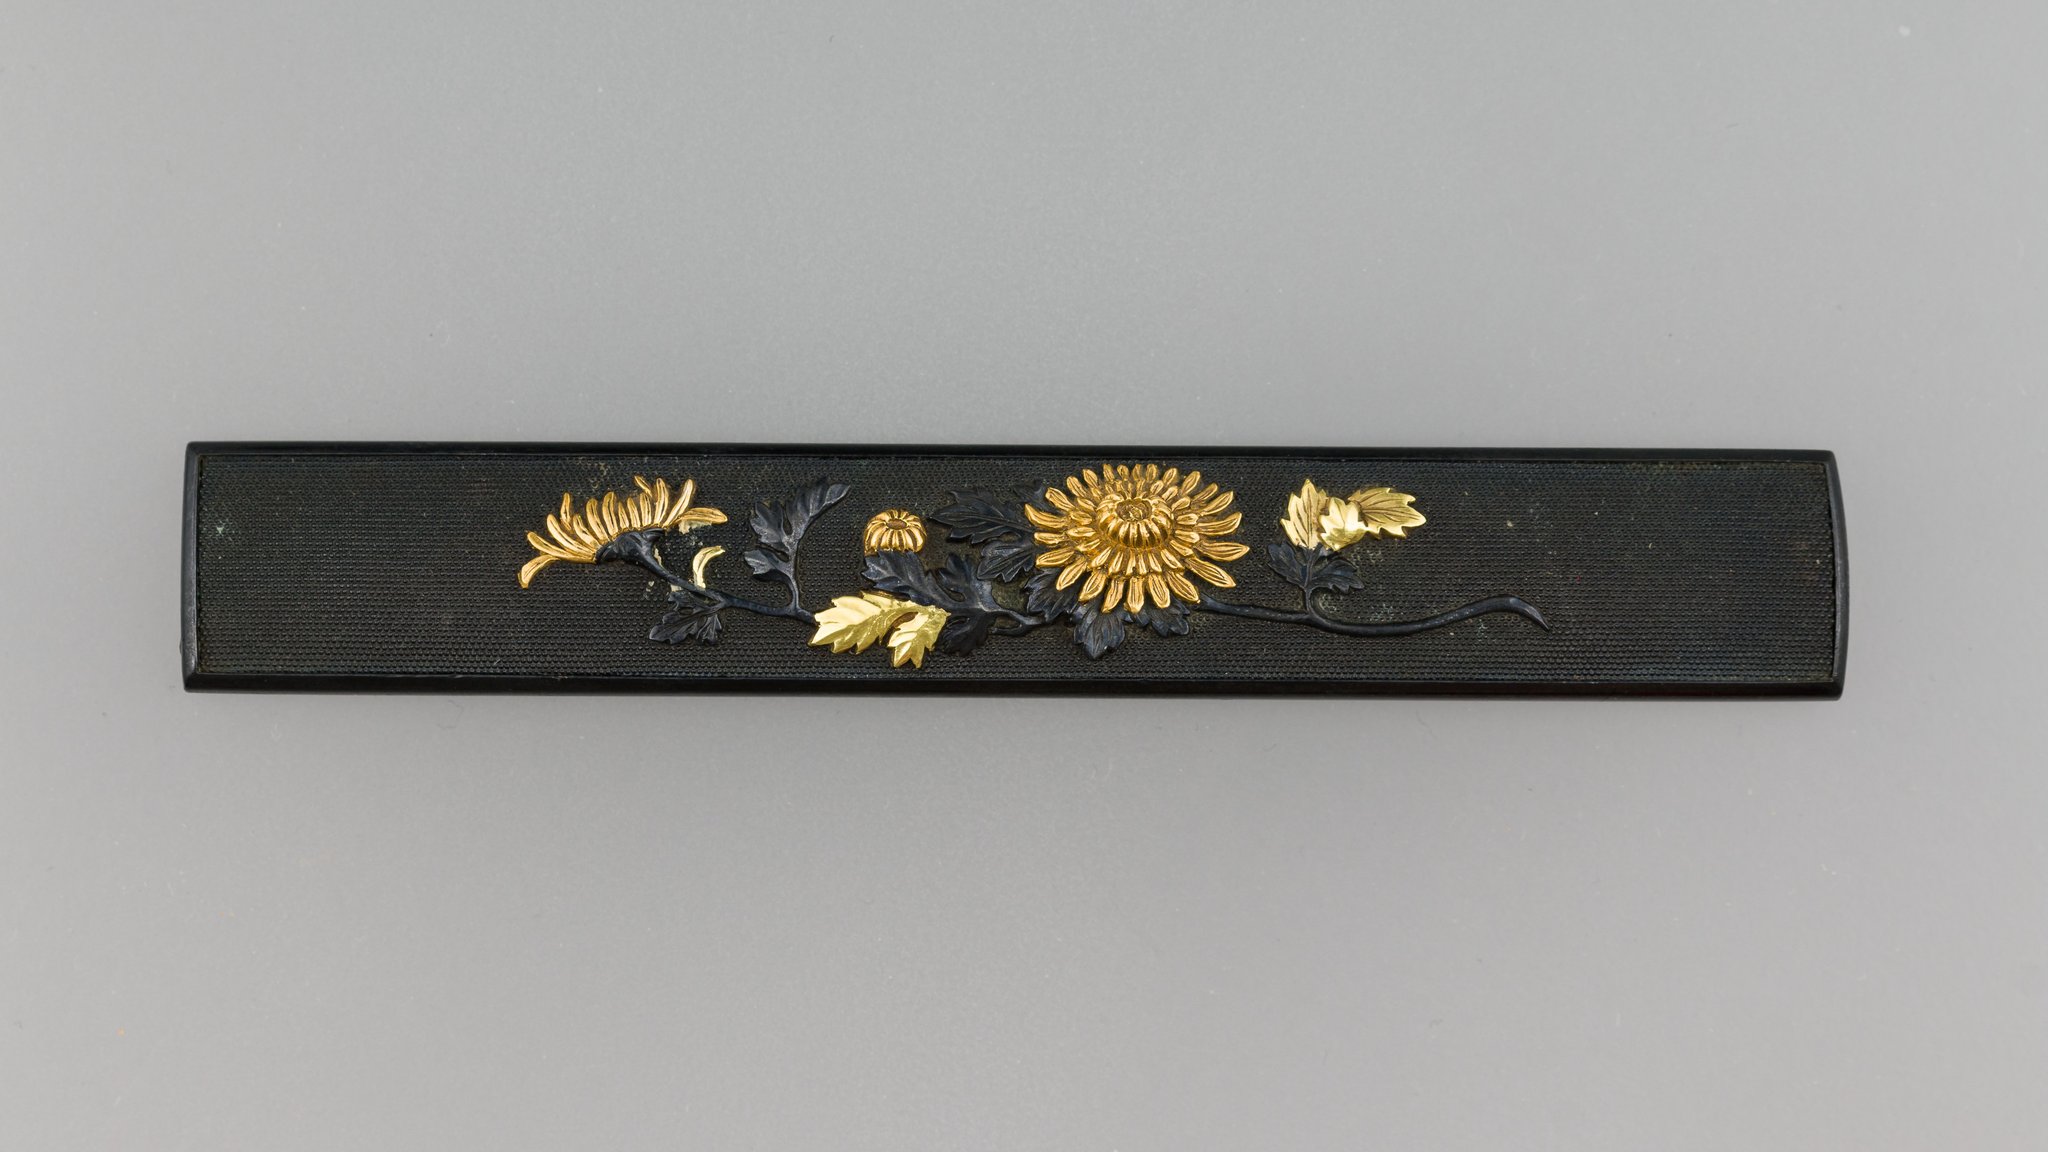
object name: knife handle kozuka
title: Knife Handle (Kozuka)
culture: japanese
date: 1834-1866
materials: gold alloy, gold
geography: japan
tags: flowers